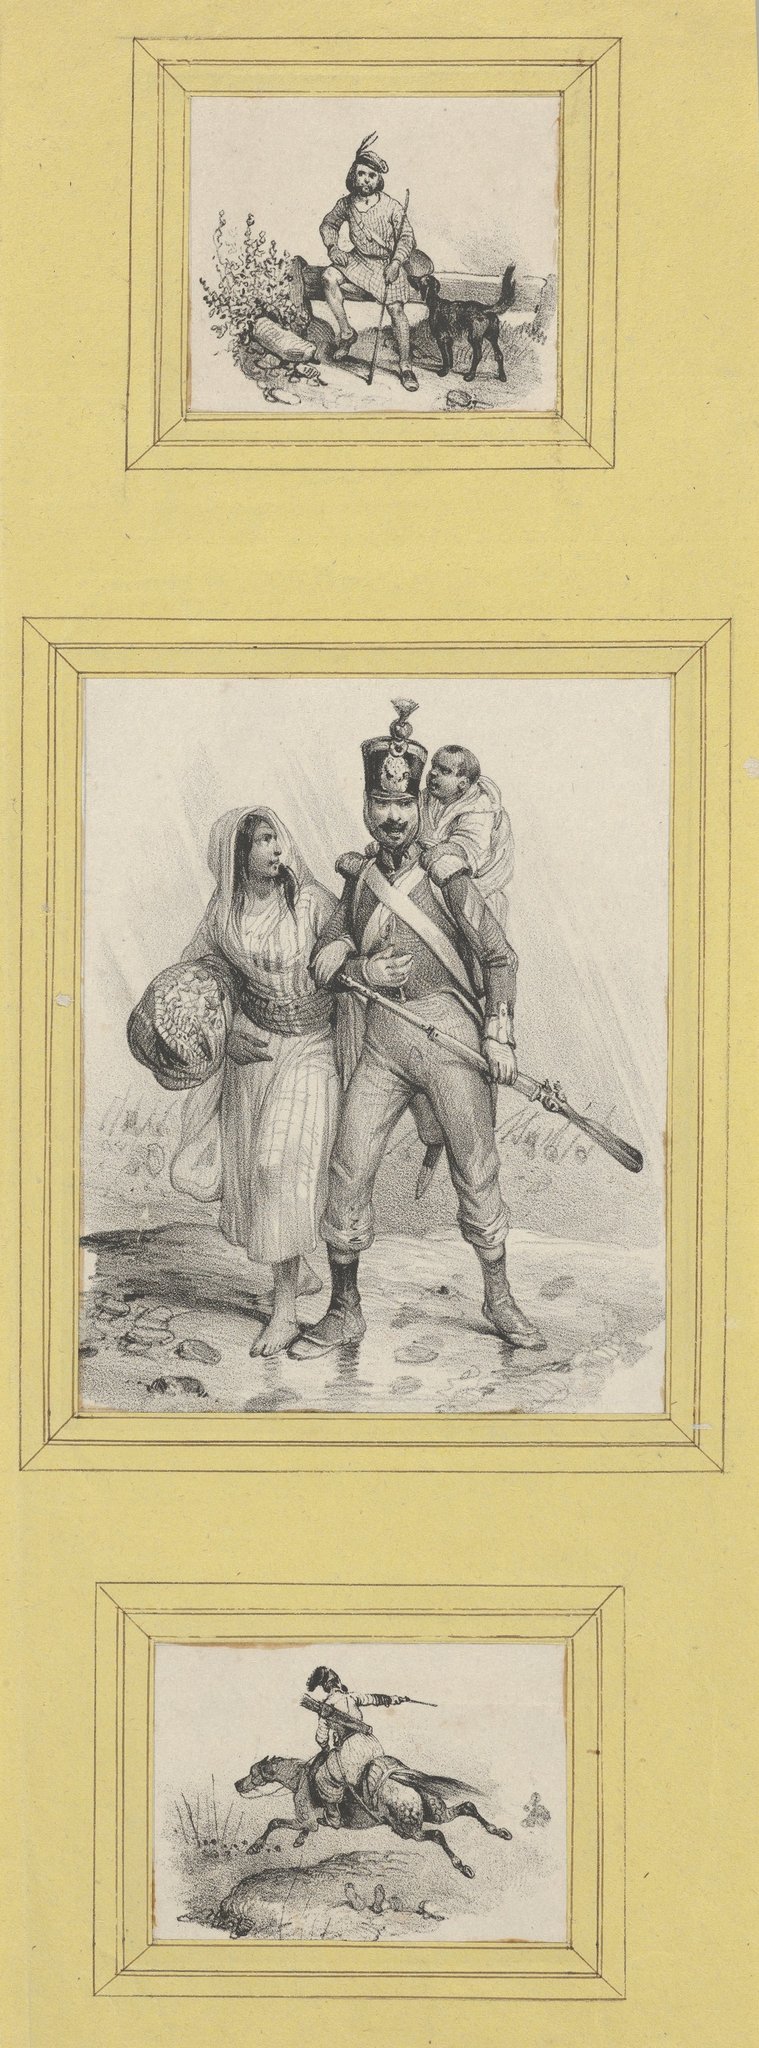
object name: print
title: Soldiers and a Highlander (3 prints of varying size pasted onto a yellow sheet)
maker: victor adam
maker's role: artist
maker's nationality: french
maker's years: 1801-1866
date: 1834-1866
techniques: lithograph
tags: soldiers,men,women,dogs,horses